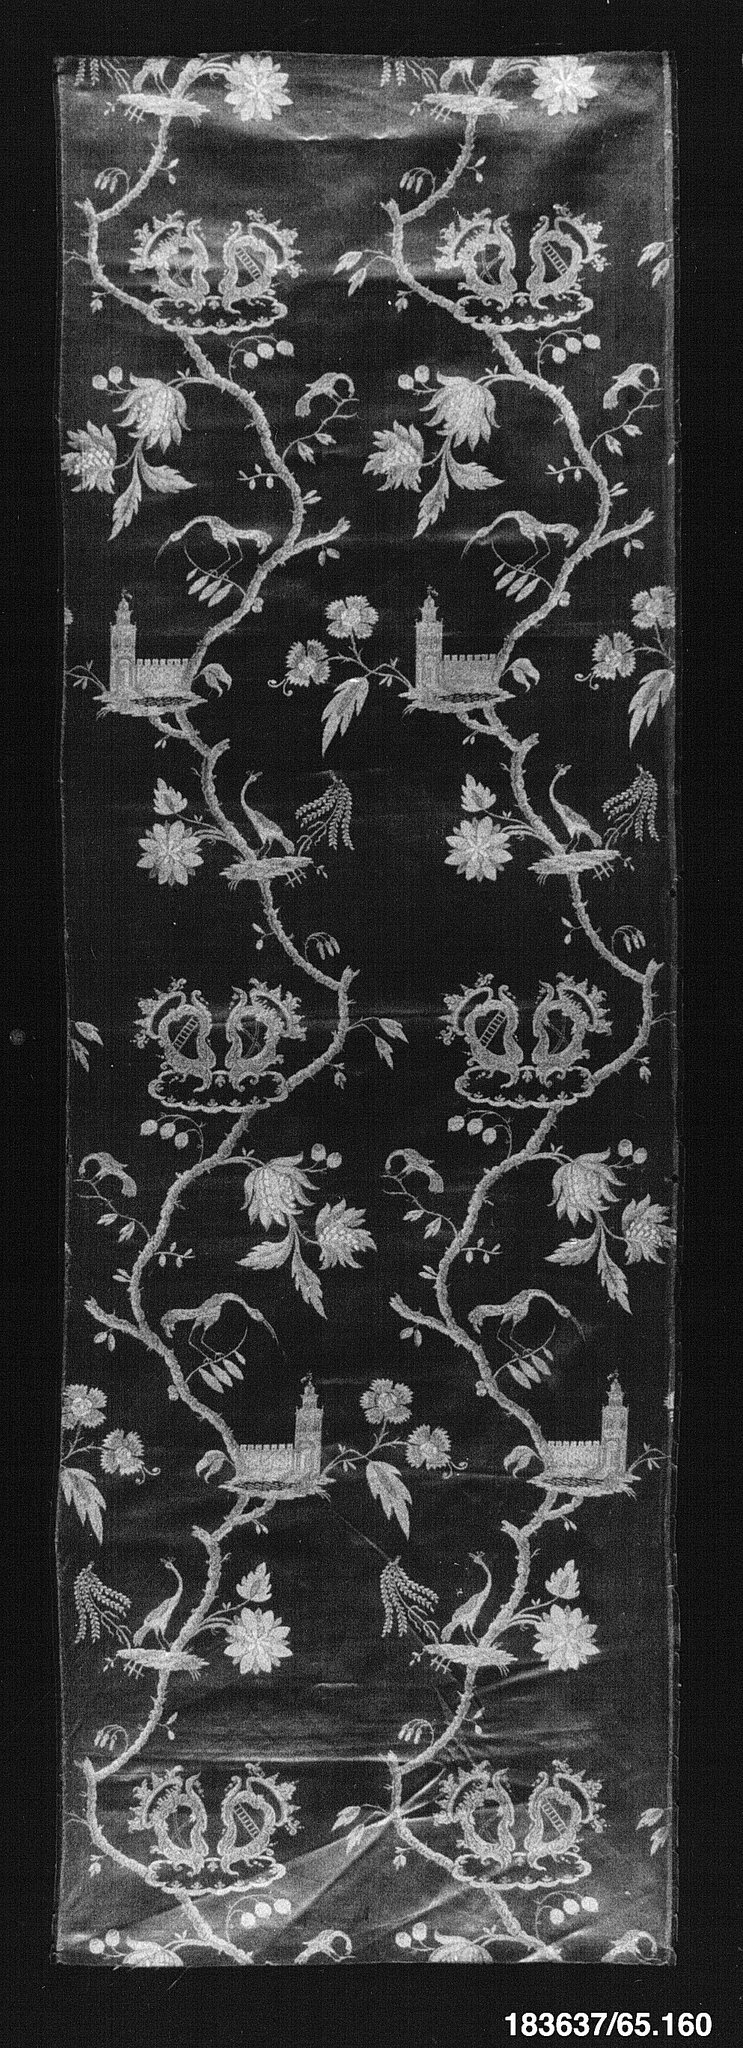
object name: piece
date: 1701-1800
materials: silk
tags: birds,flowers